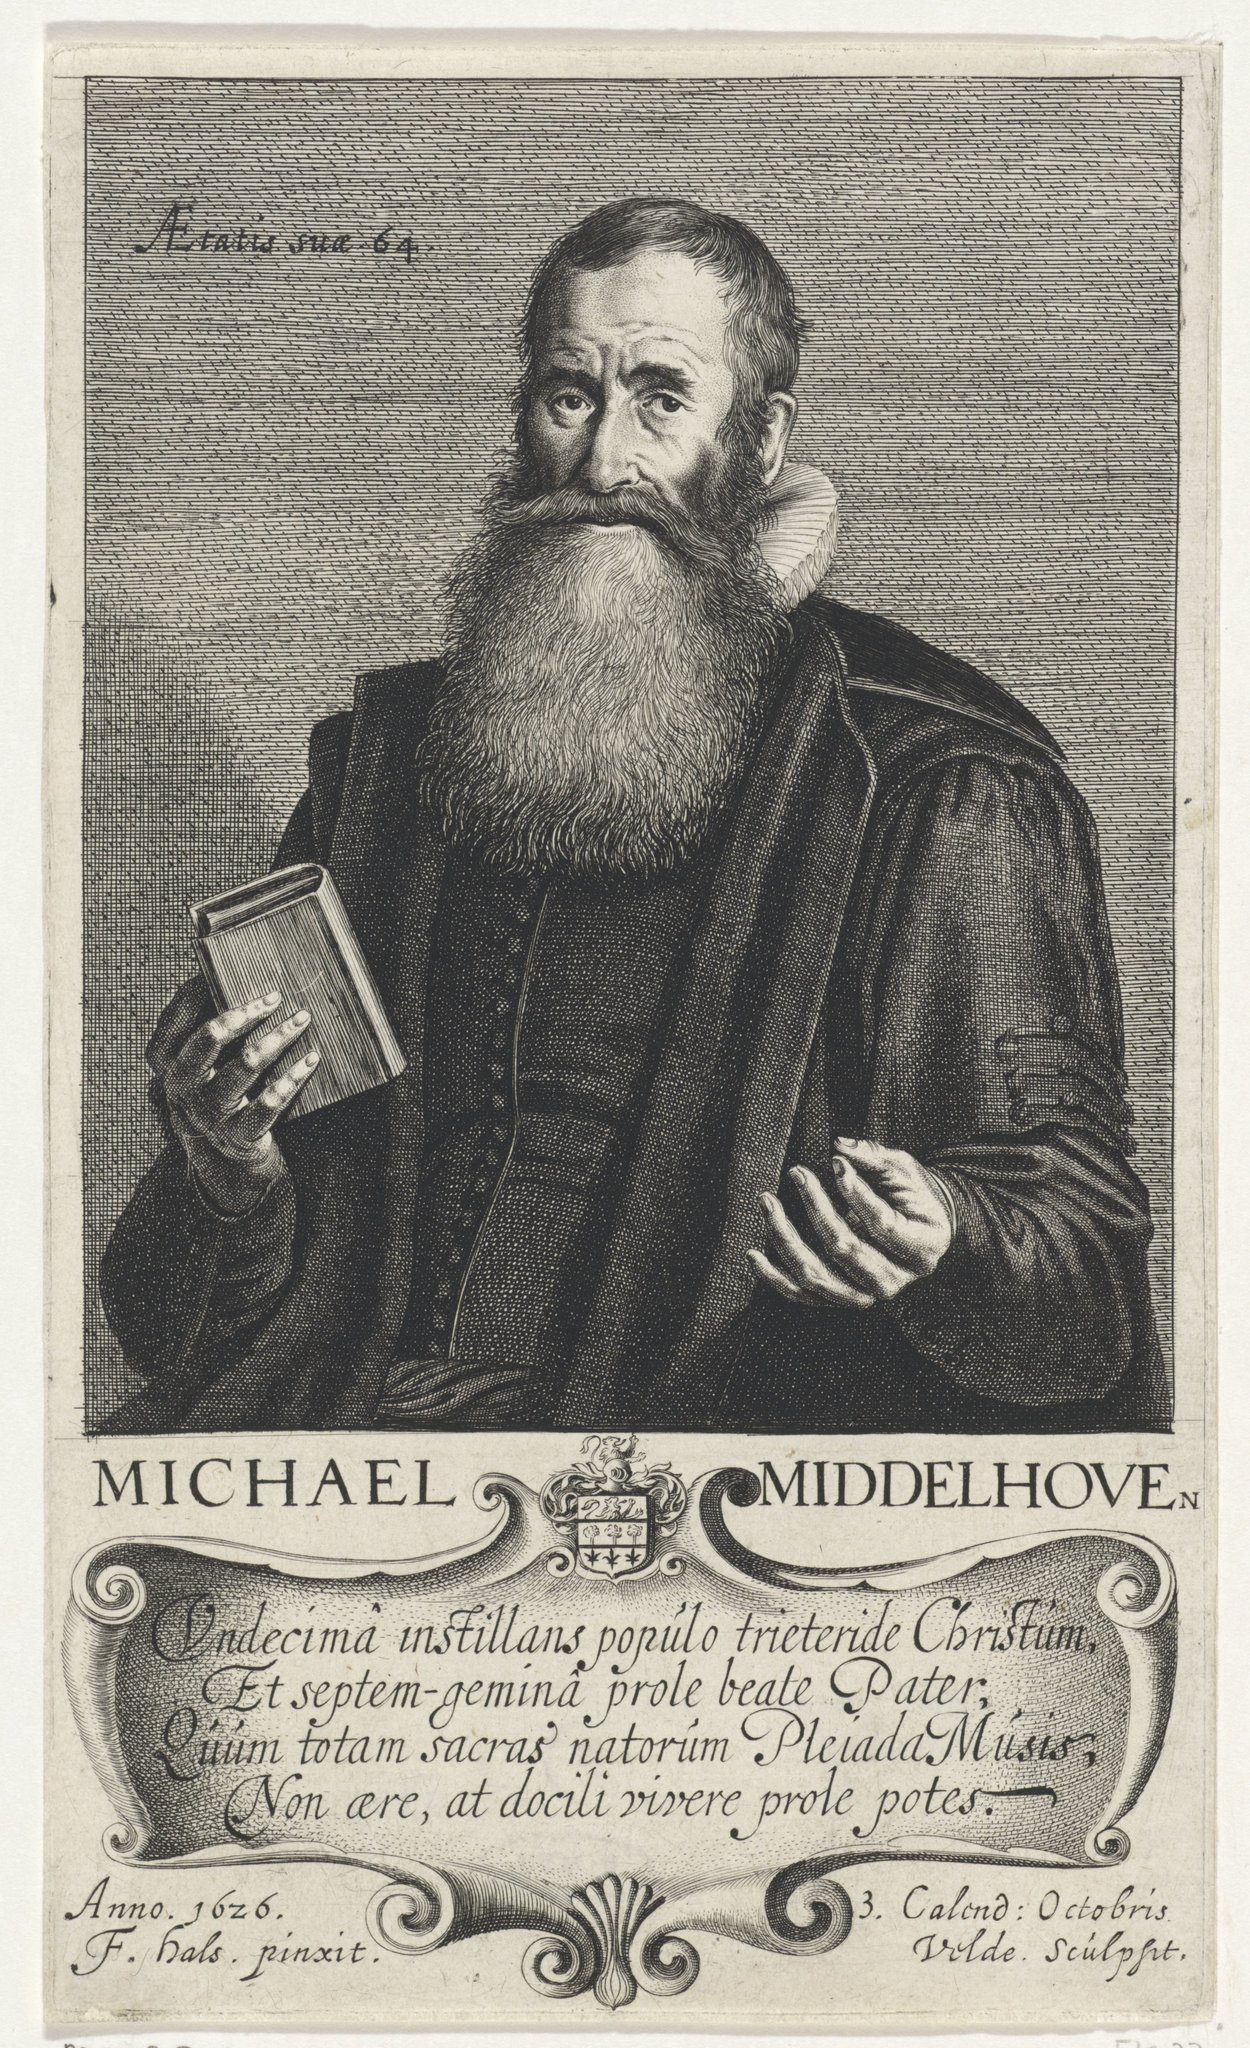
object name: print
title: Portret van Michiel Jansz. van Middelhoven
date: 1626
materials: paper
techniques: engraving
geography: northern netherlands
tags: leiden, voorschoten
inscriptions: collector's mark: Lugt 964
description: Portret van Michall van Middelhoven, predikant te Voorschoten, op 64-jarige leeftijd.